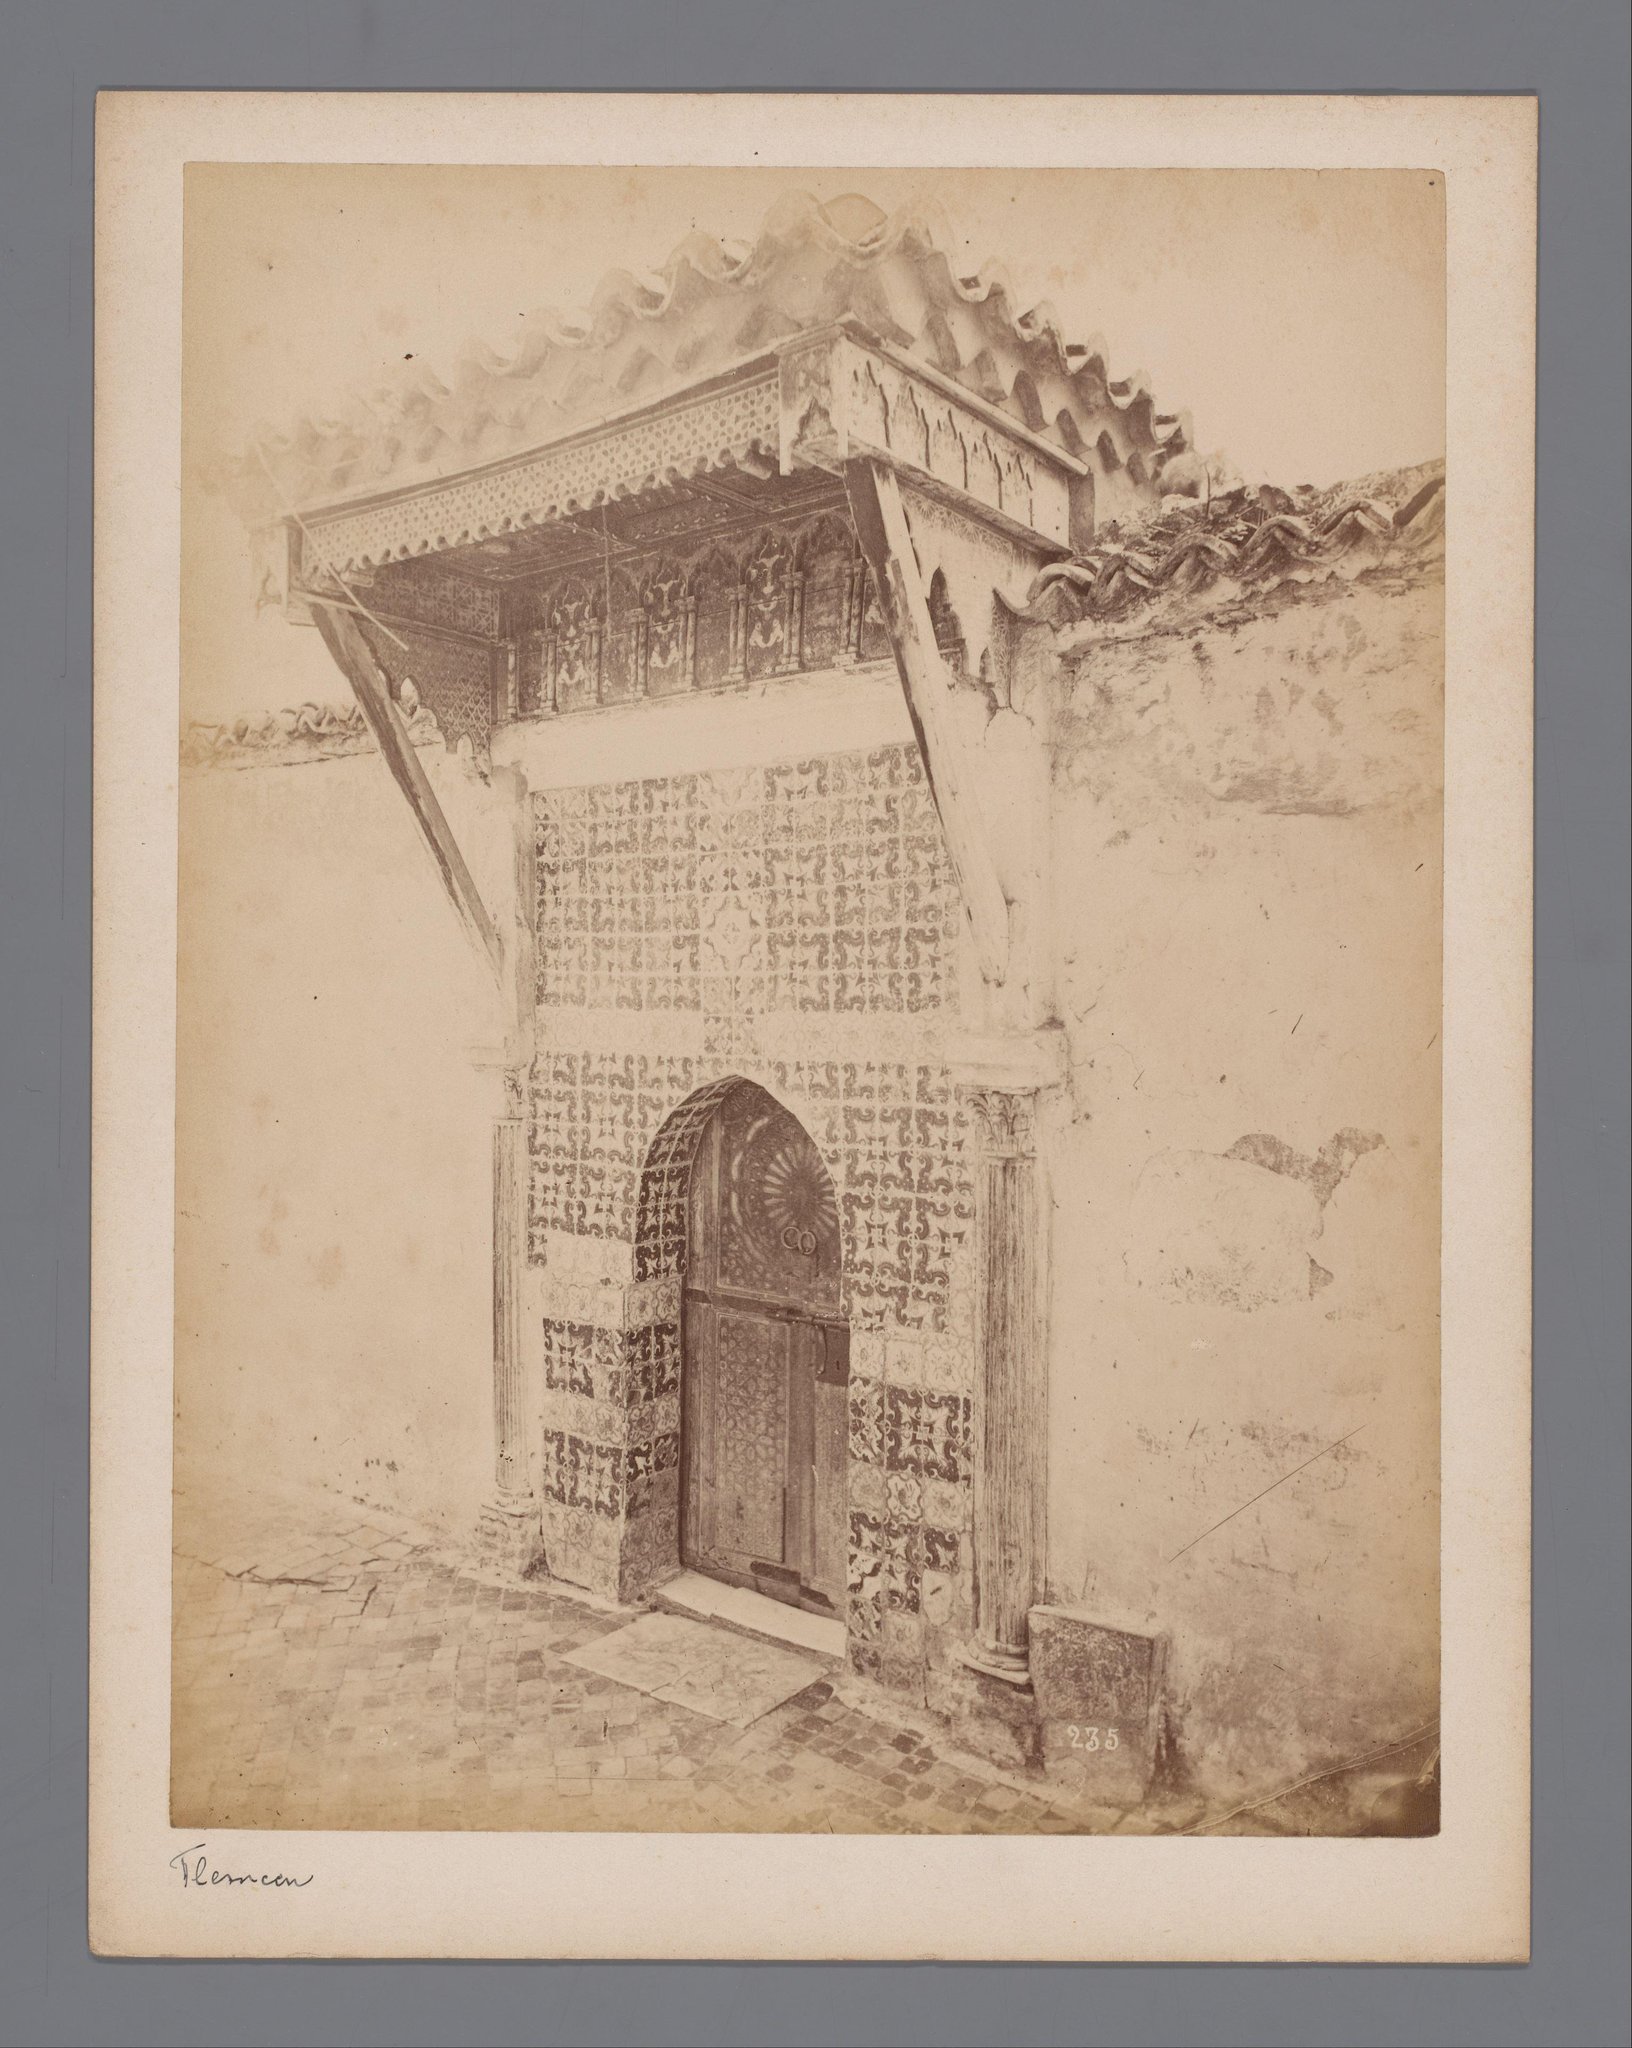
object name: photograph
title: Portaal in Tlemcen, Algerije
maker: Anonymous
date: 1860-1900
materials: cardboard, paper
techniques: albumen print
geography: tlemcen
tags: closed door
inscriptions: inscription: ‘Marokko’, number: ‘235’